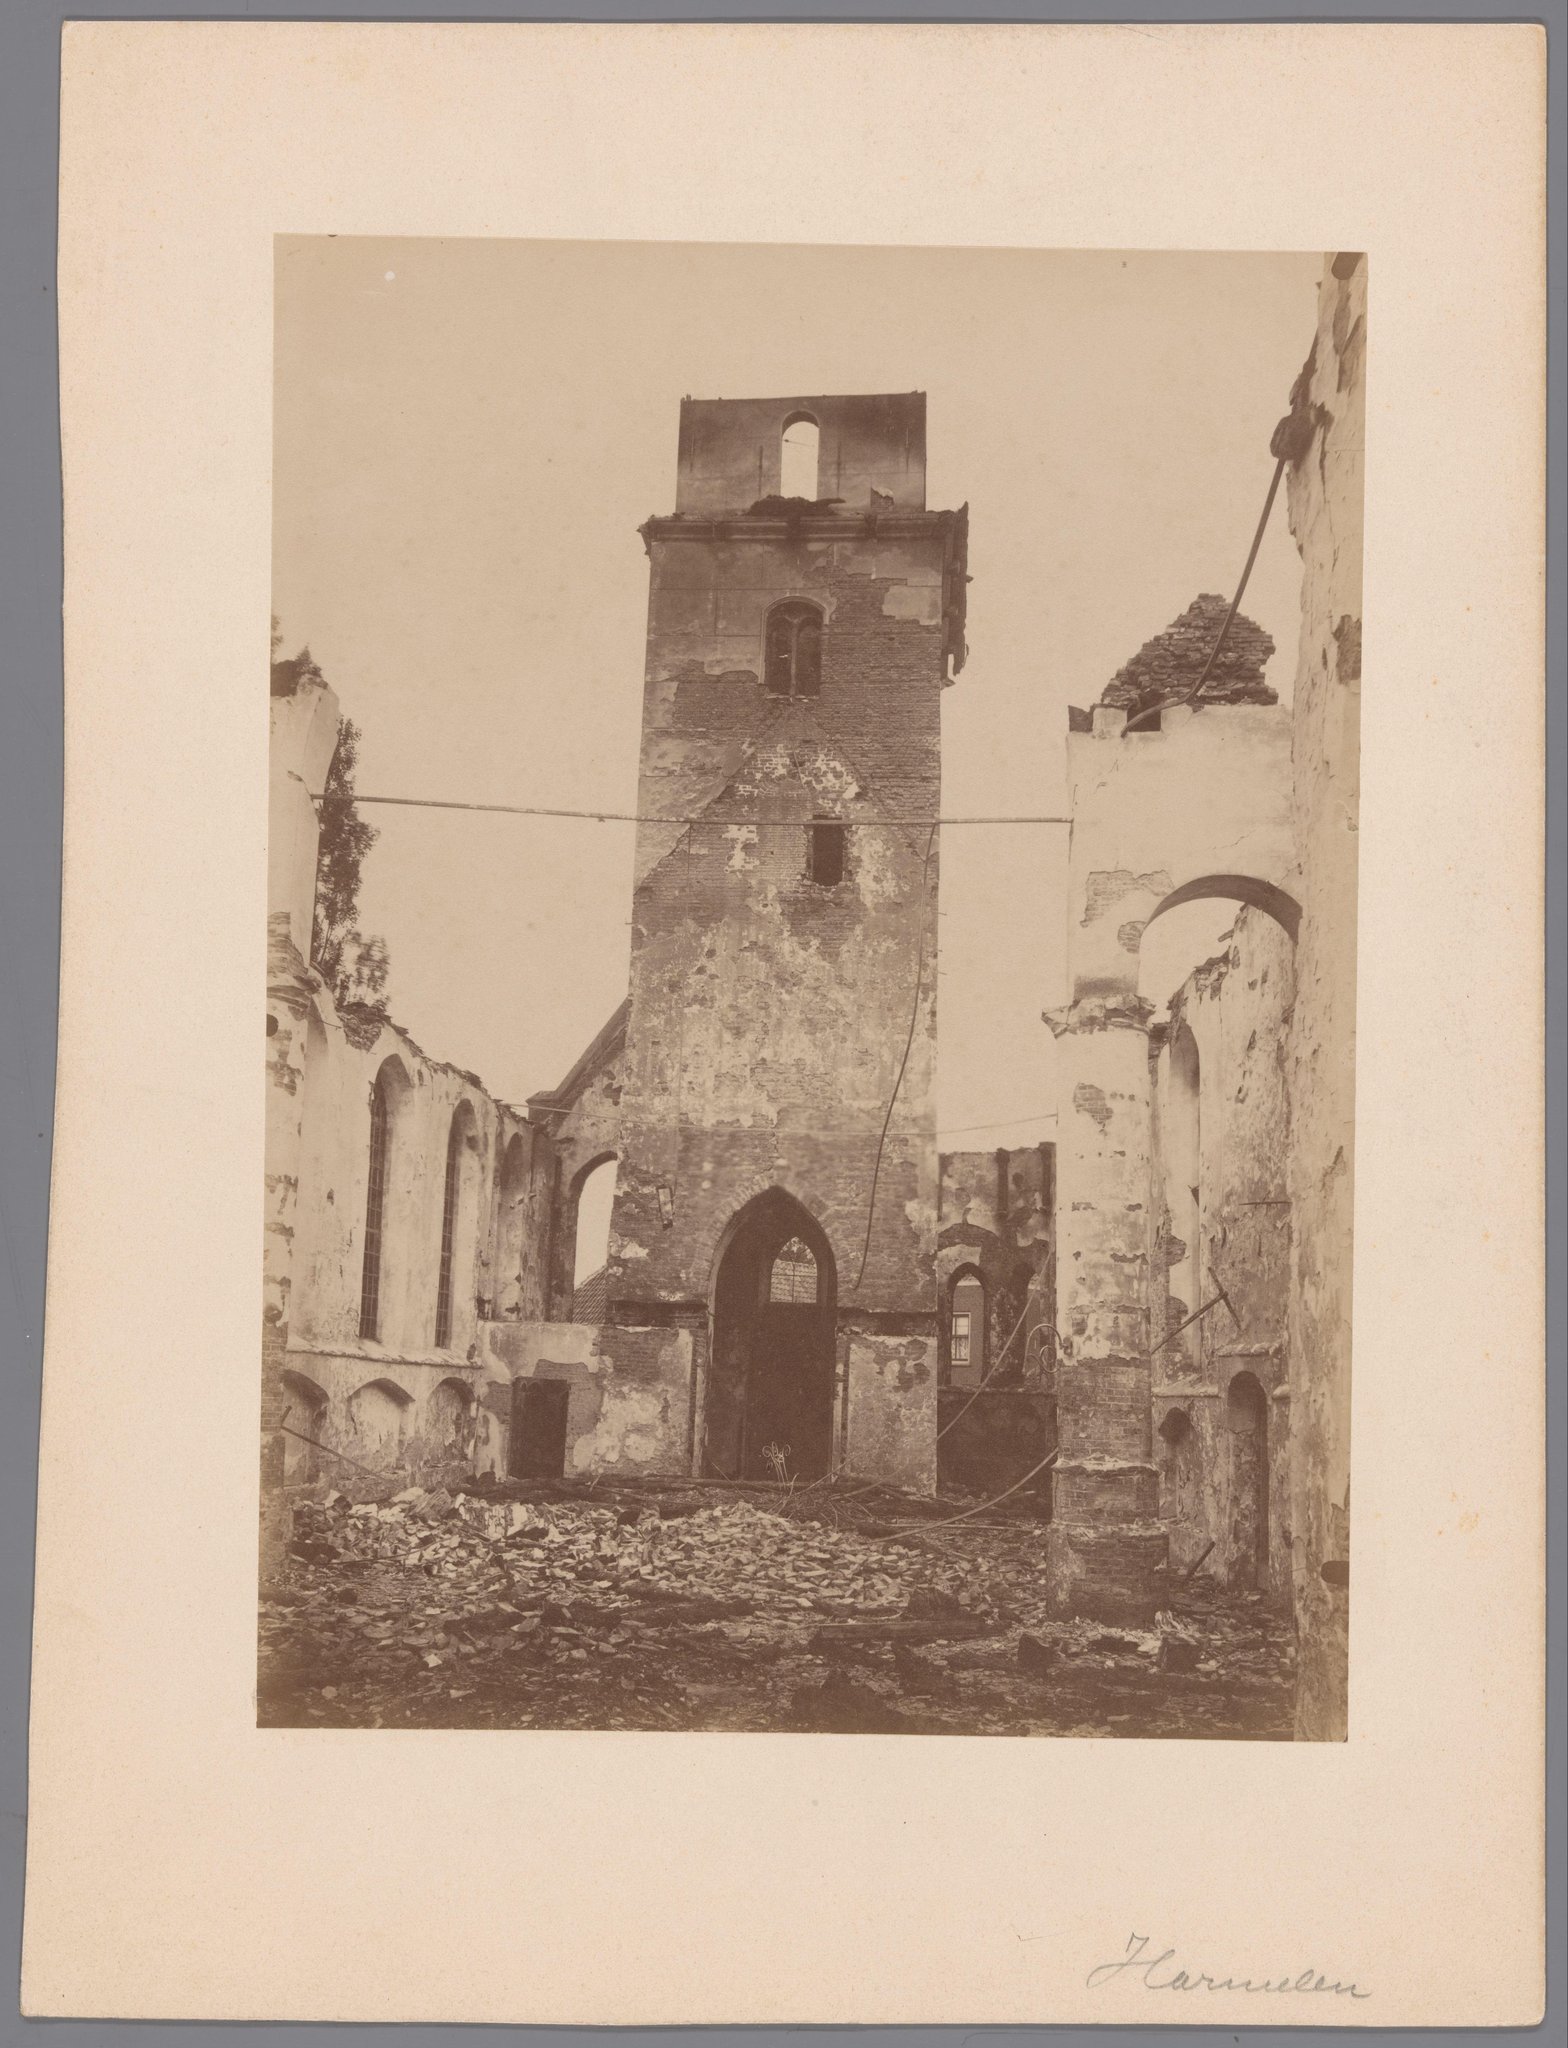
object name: photograph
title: Interieur van de afgebrande Hervormde Kerk te Harmelen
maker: anoniem (monumentenzorg)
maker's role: fotograaf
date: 1900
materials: cardboard, photographic support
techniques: albumen print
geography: harmelen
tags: interior of church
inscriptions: annotation: ‘Harmelen’, annotation: ‘N.H. kerk te Harmelen (U.)/ oostzijde v/d toren na den brand in juni 1900’